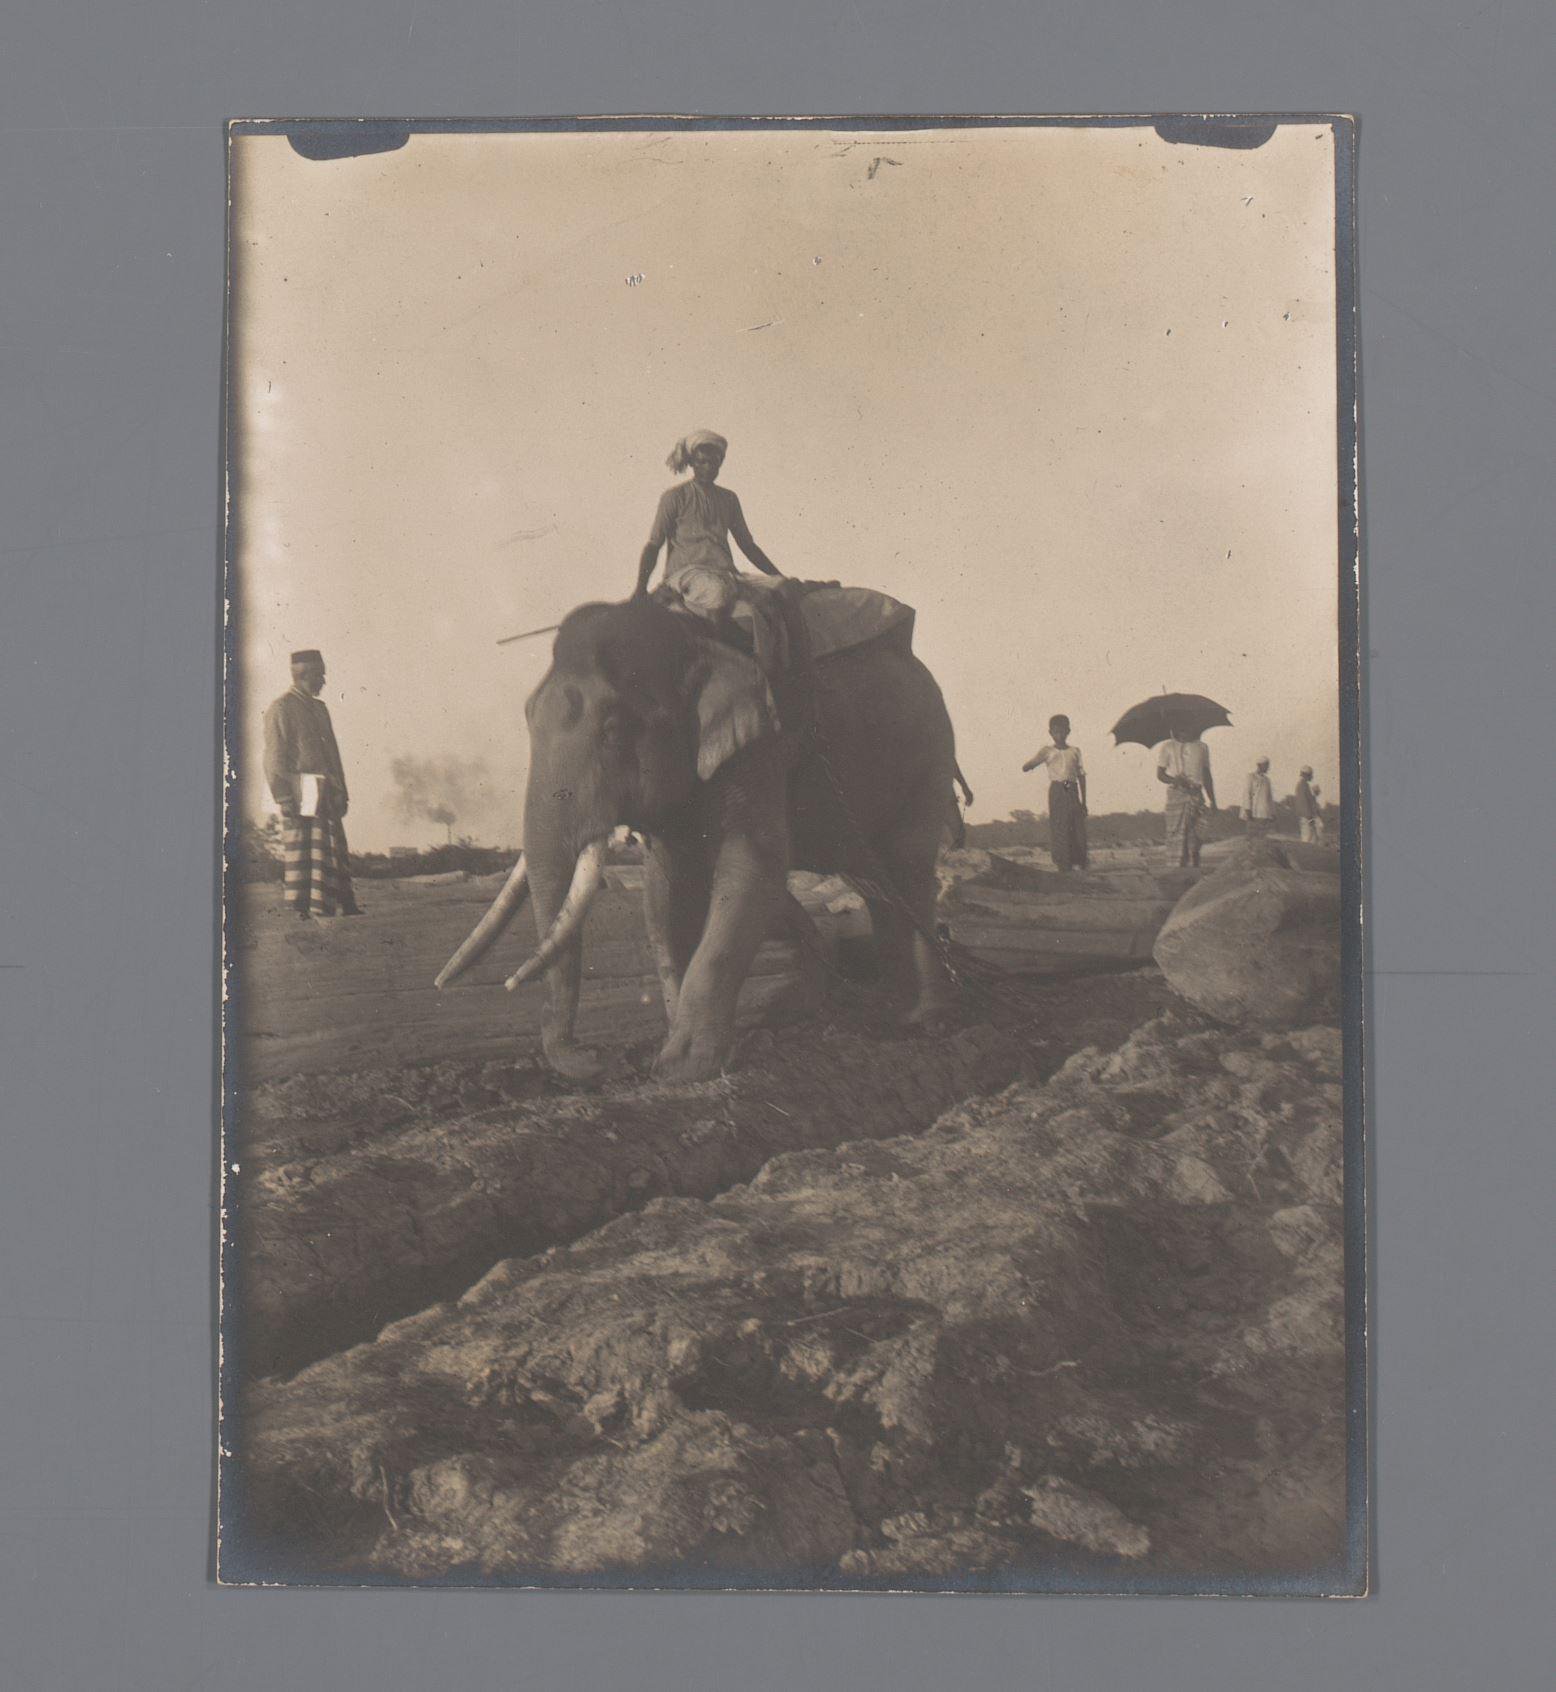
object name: photograph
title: An elephant with its rider dragging a tree trunk, India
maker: jan adriani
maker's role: fotograaf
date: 1907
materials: photographic support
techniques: gelatin silver print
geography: india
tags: trunked animals: elephant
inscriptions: inscription: ‘orig foto/ 10,-/ AE 98’